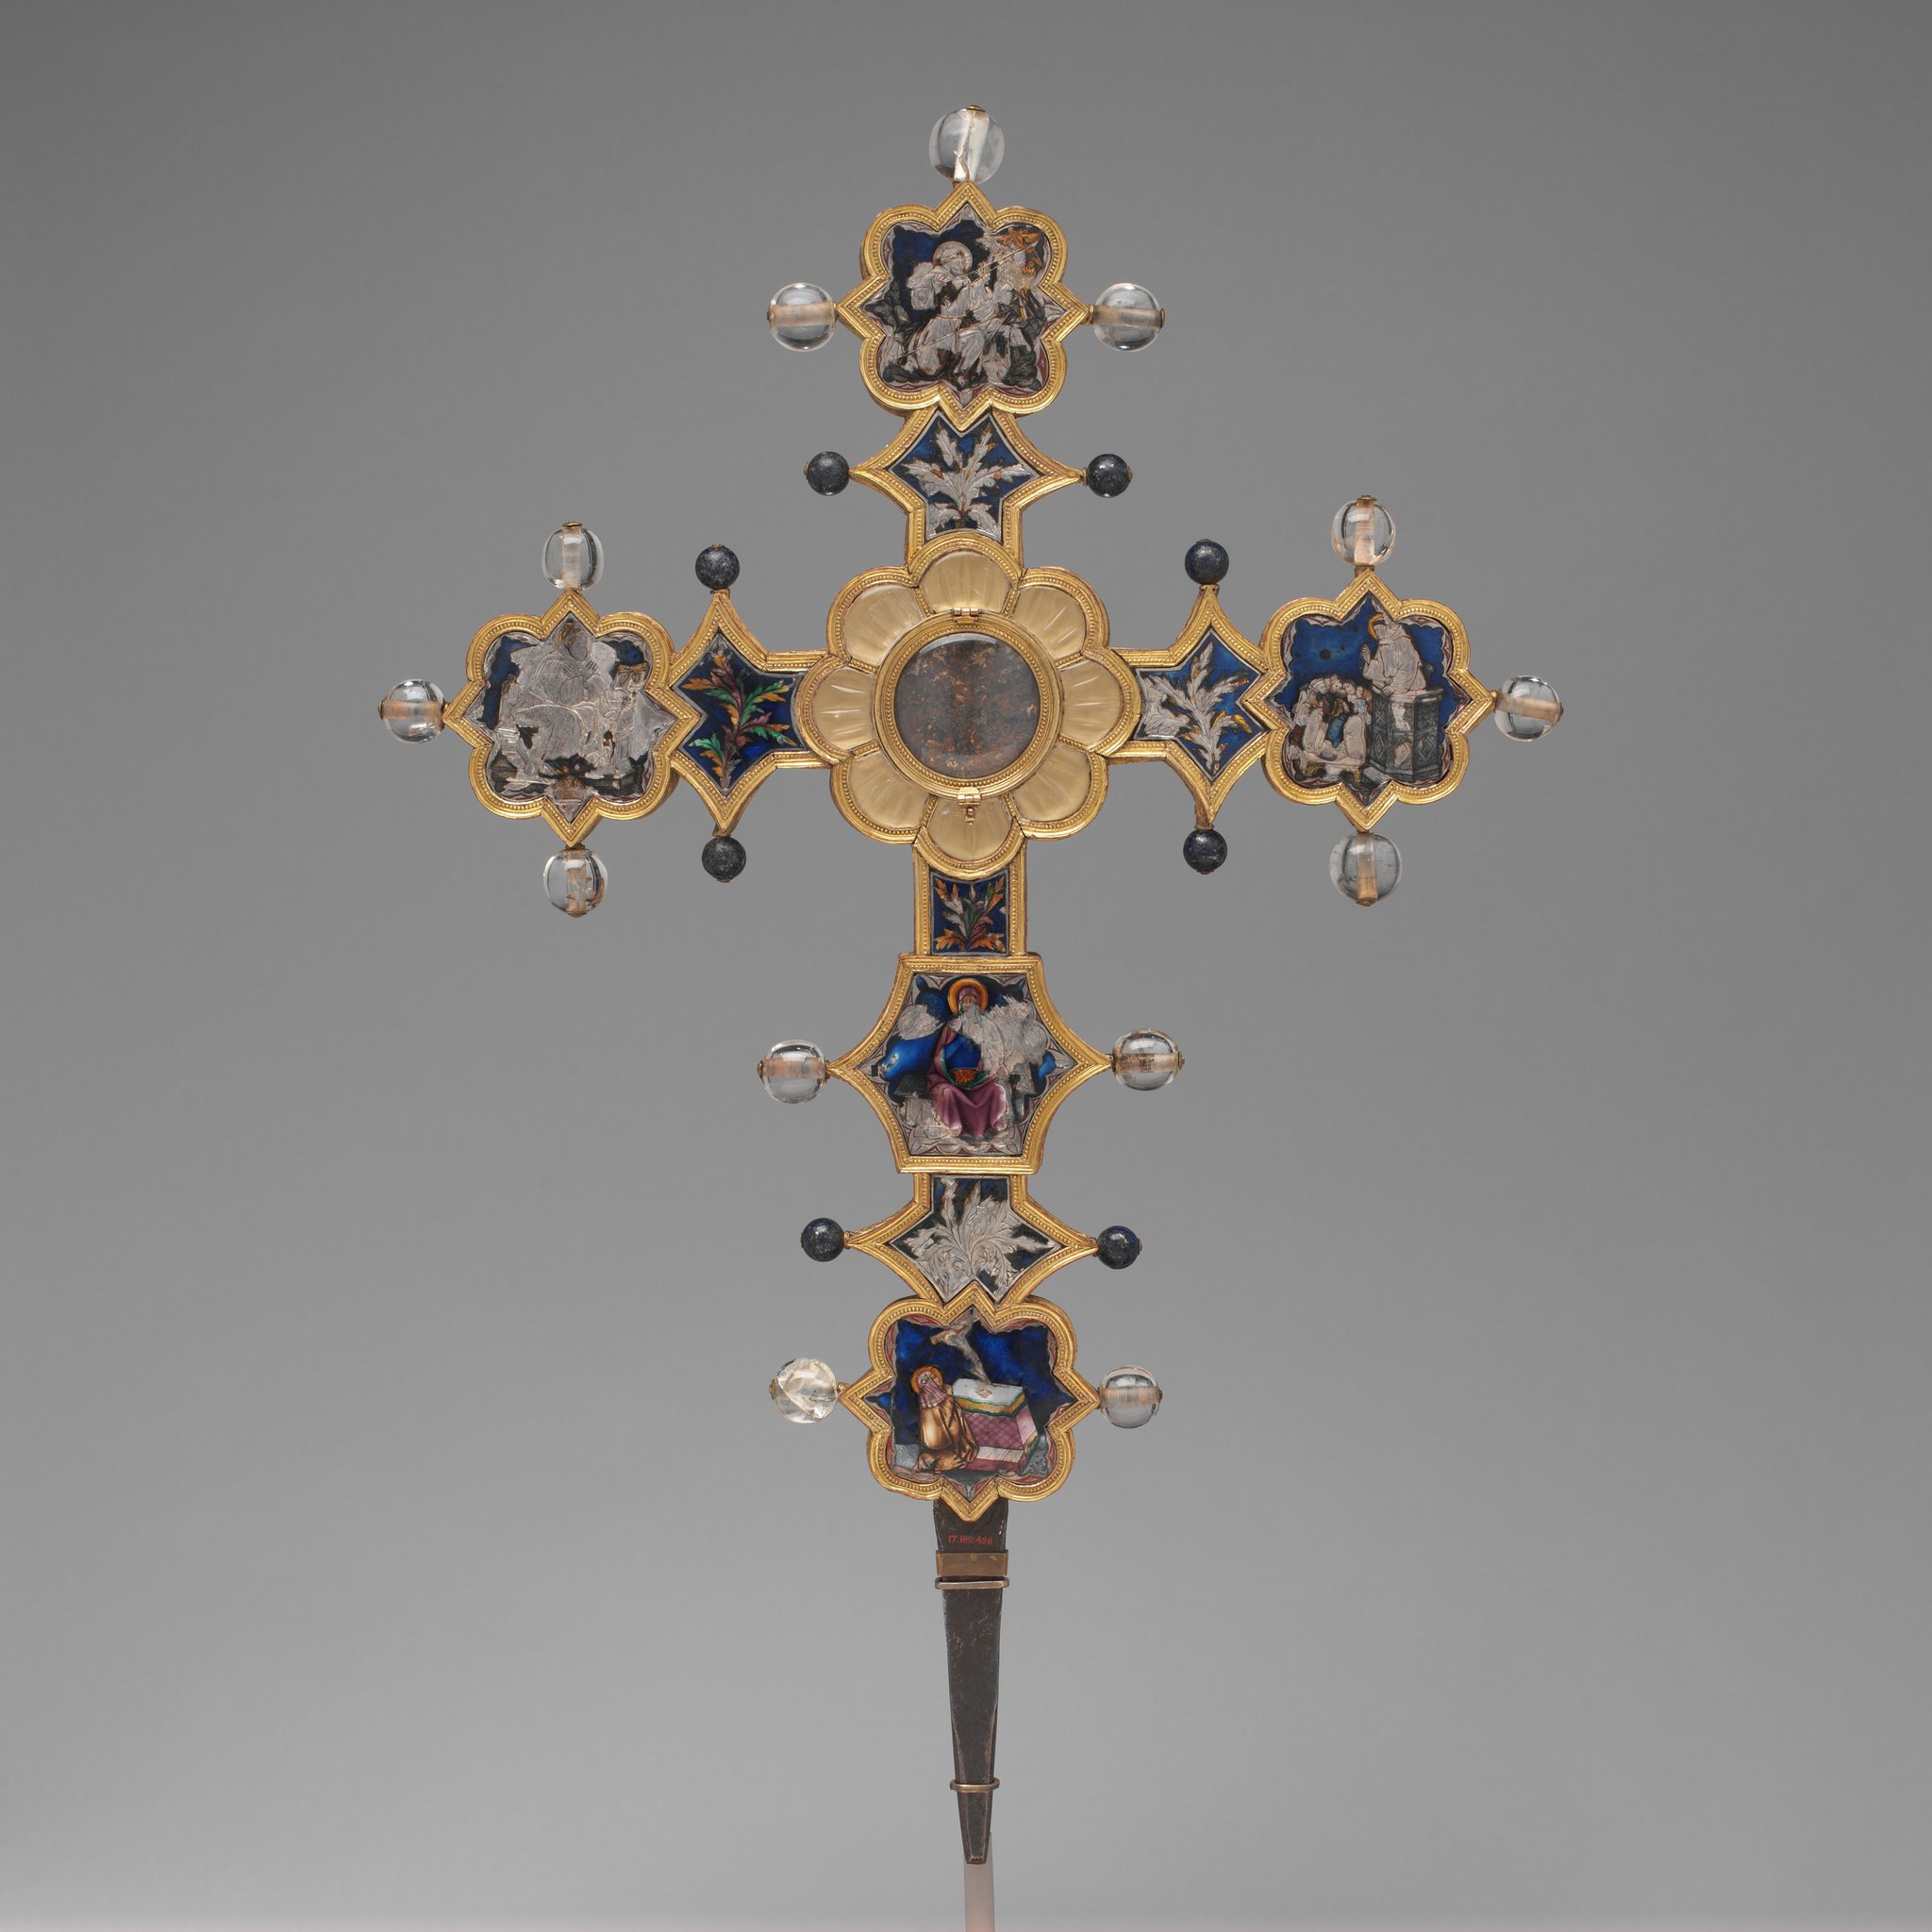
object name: reliquary cross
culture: italian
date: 1366-1400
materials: enamel, glass, iron, quartz, silver, silver gilt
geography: italy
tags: christ,virgin mary,annunciation,nativity,evangelists